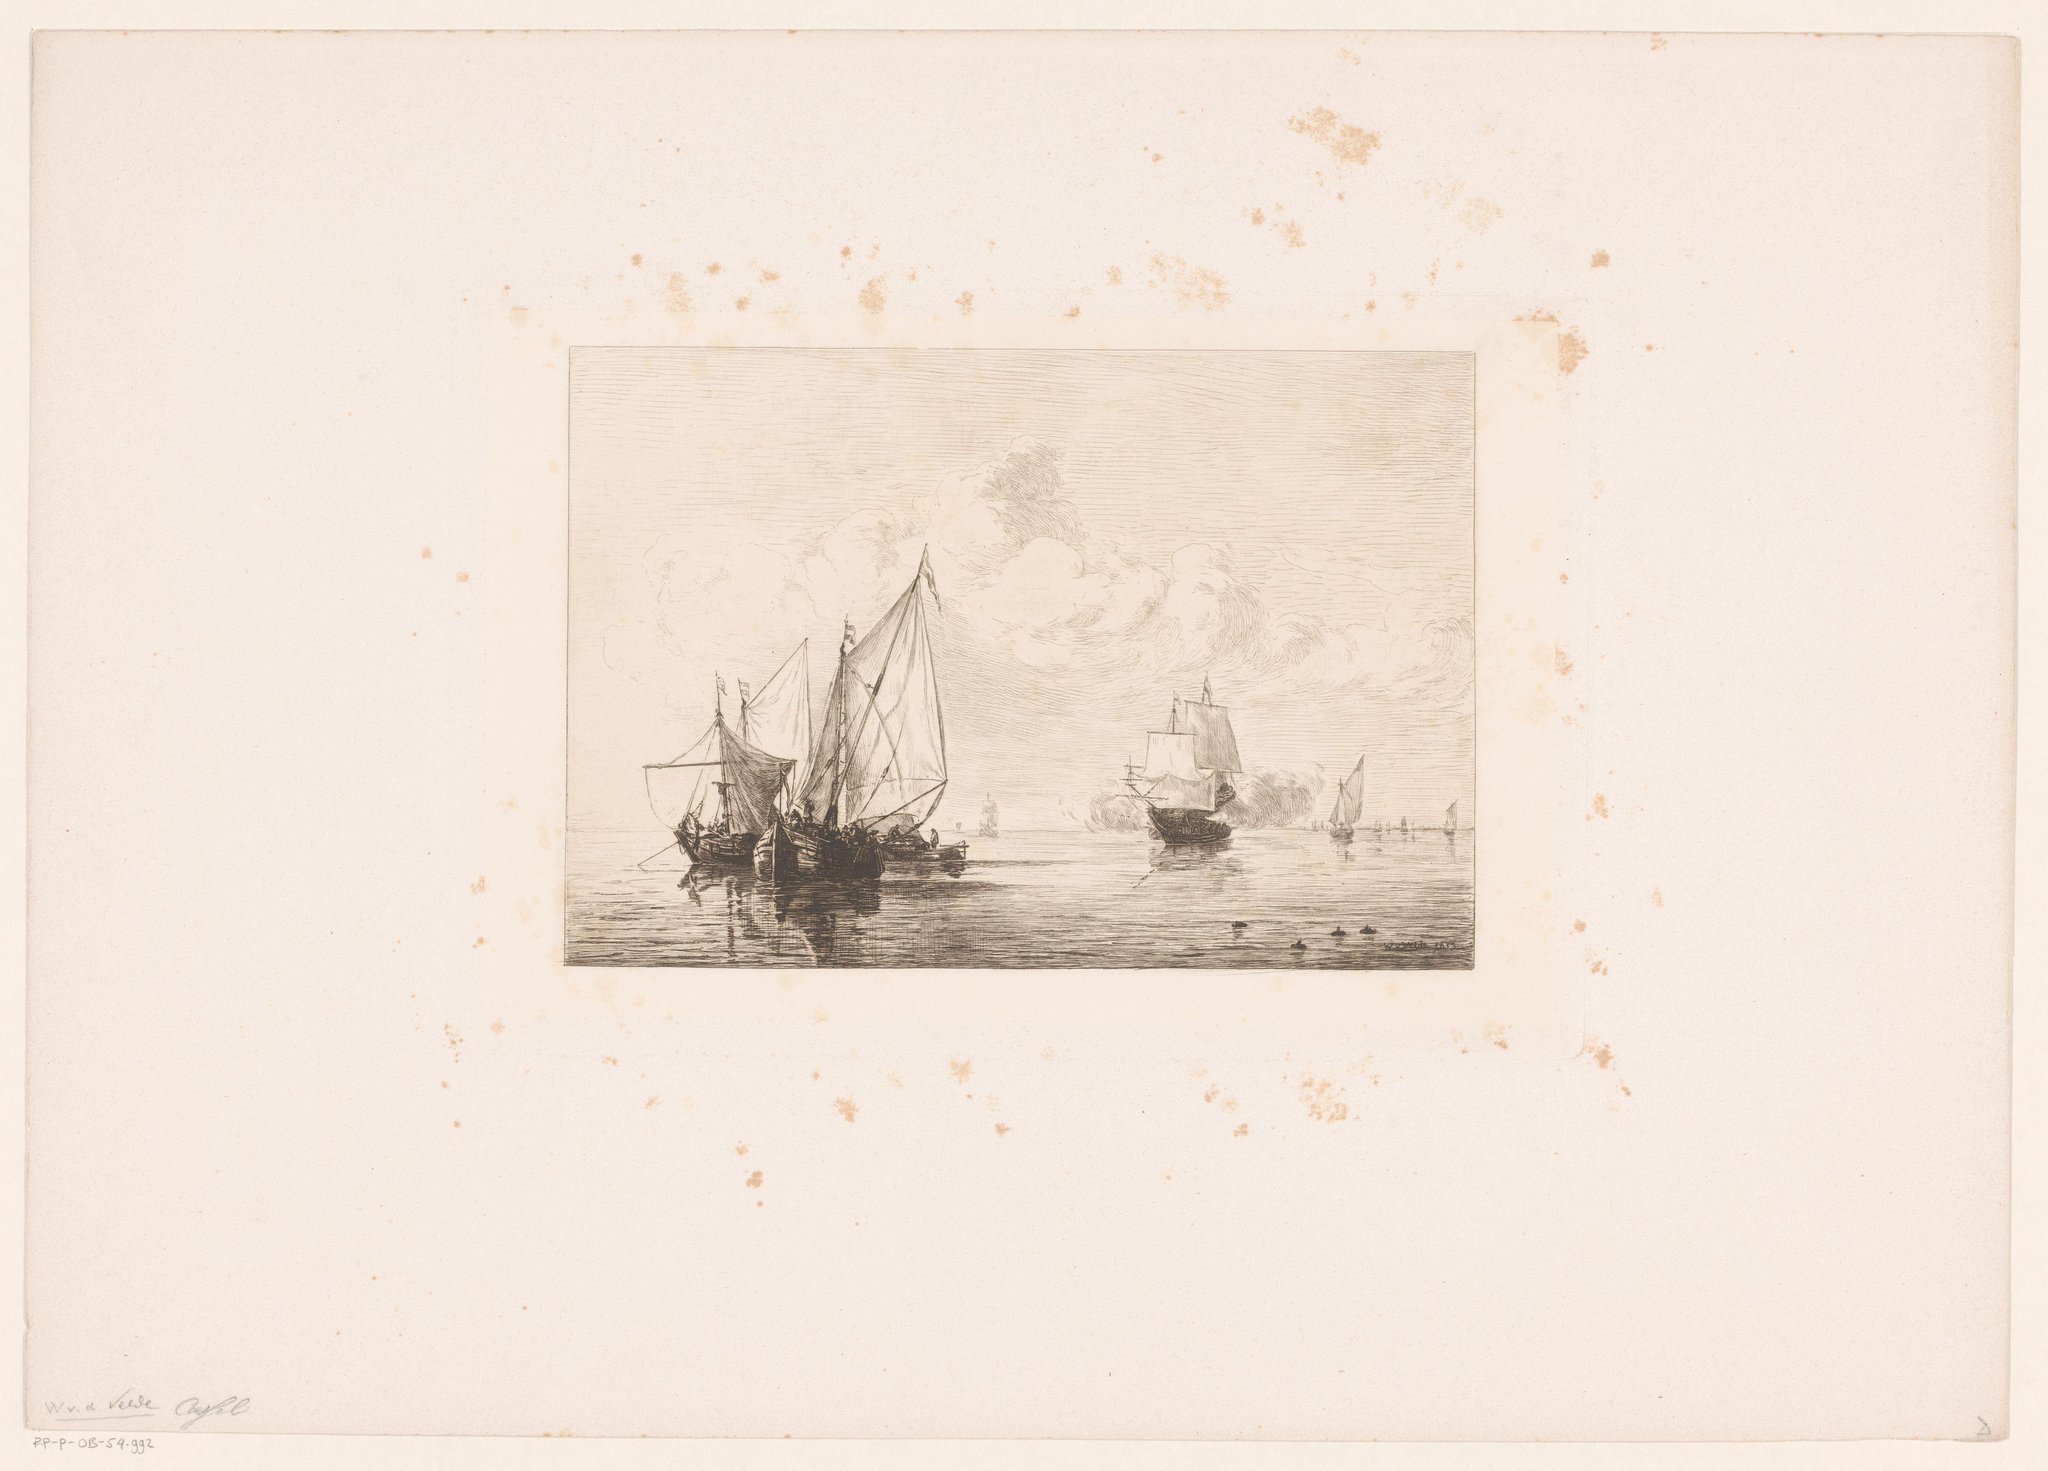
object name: print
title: Schepen op zee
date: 1847-1889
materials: paper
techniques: etching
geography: germany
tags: sailing-ship, sailing-boat, landscapes with waters, waterscapes, seascapes (in the temperate zone)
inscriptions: collector's mark: Lugt 2228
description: Prent naar het schilderij door Willem van de Velde II in de Gemäldegalerie Alte Meister te Kassel (inv.nr. GK 420).